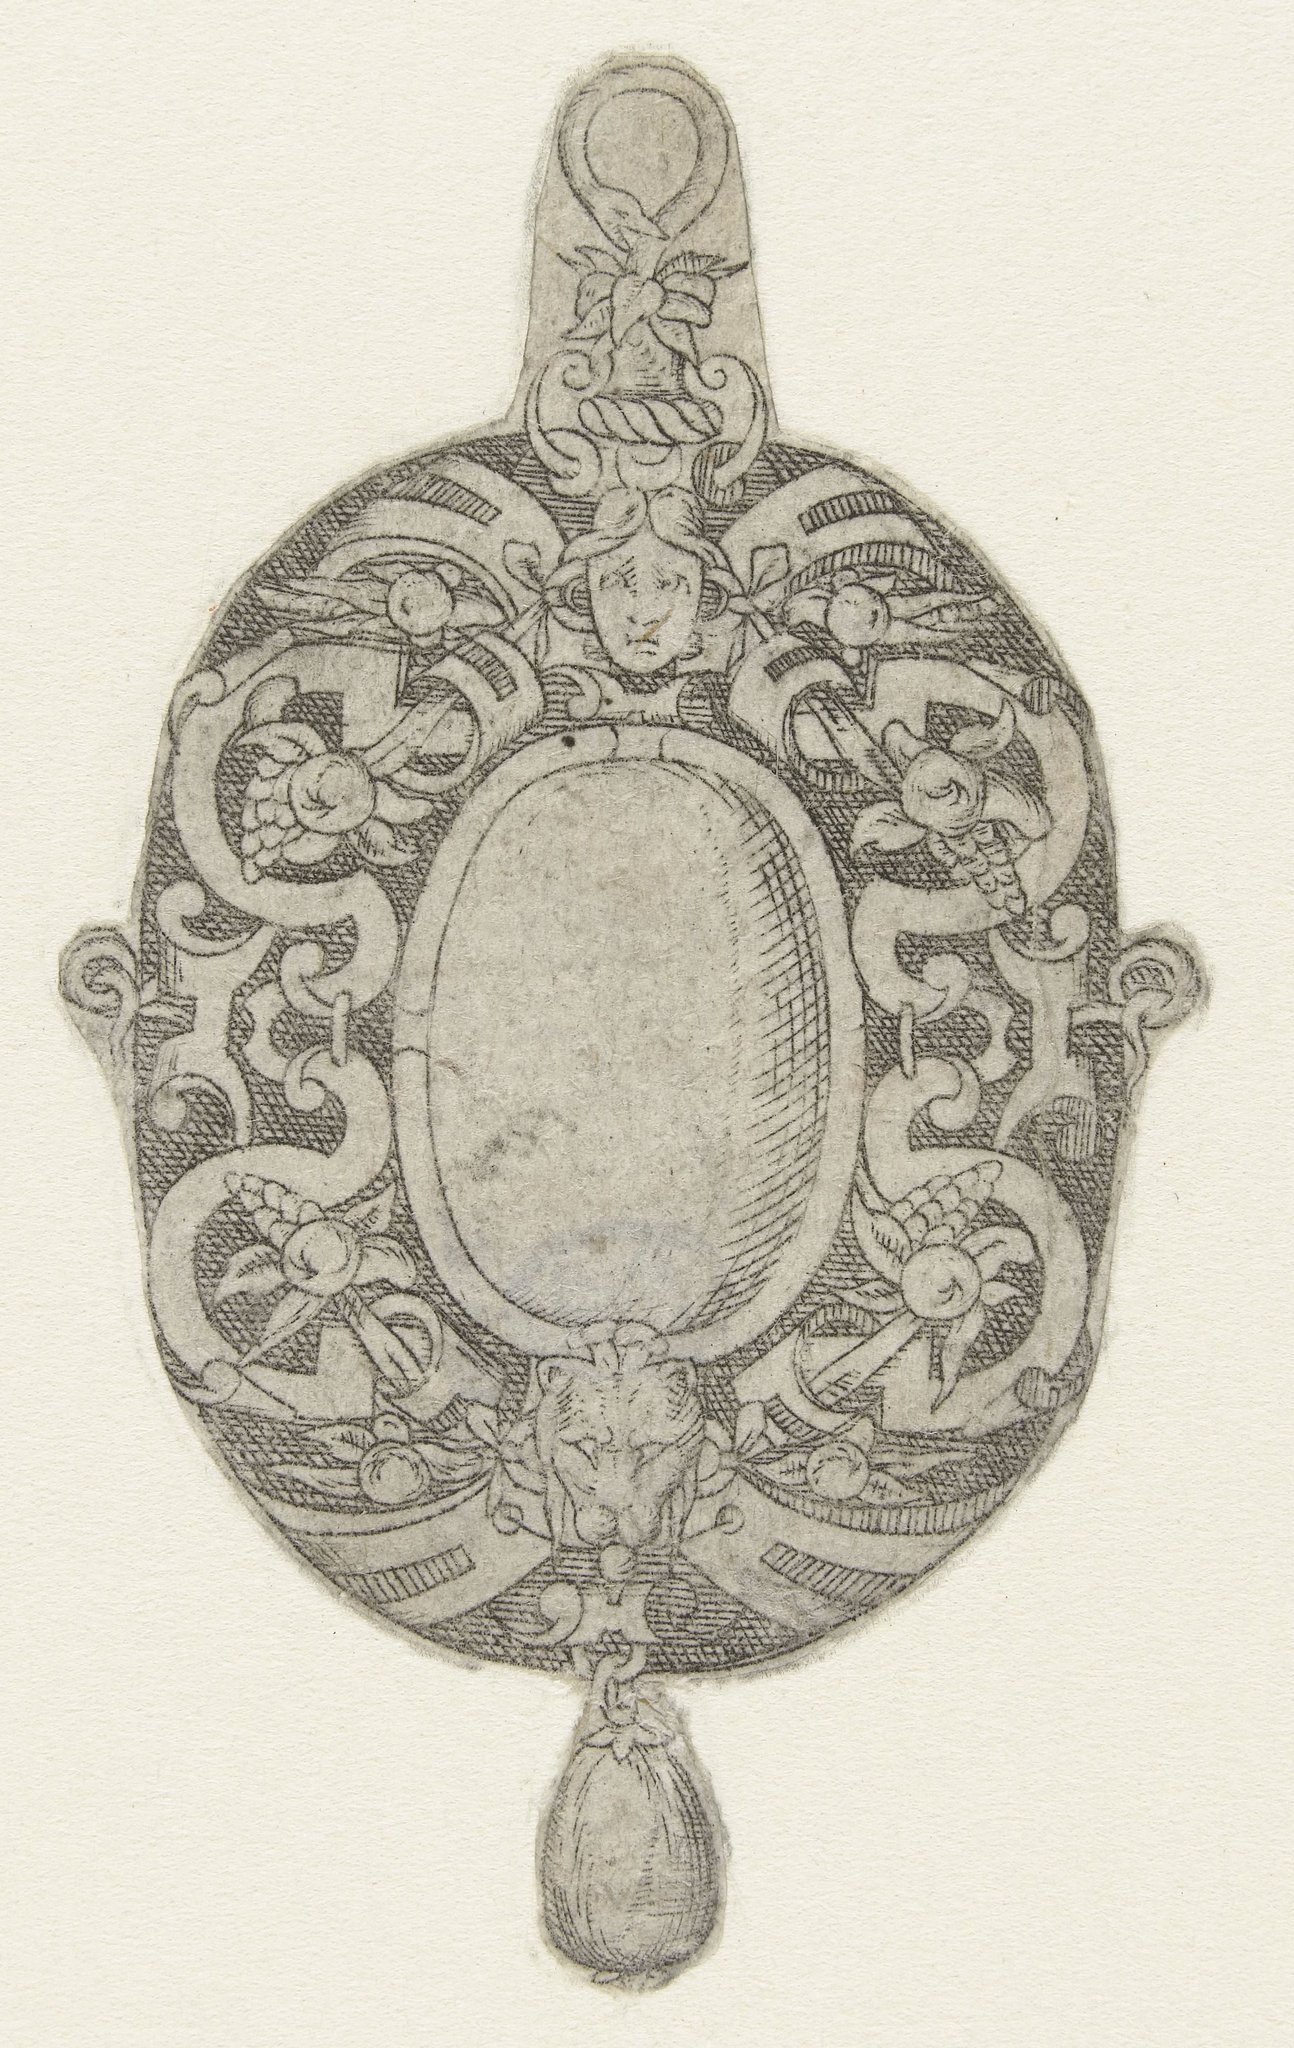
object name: ornament print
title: Ovale hanger met een steen in een omlijsting van rolwerk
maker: Anonymous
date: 1500-1600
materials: paper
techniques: etching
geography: france